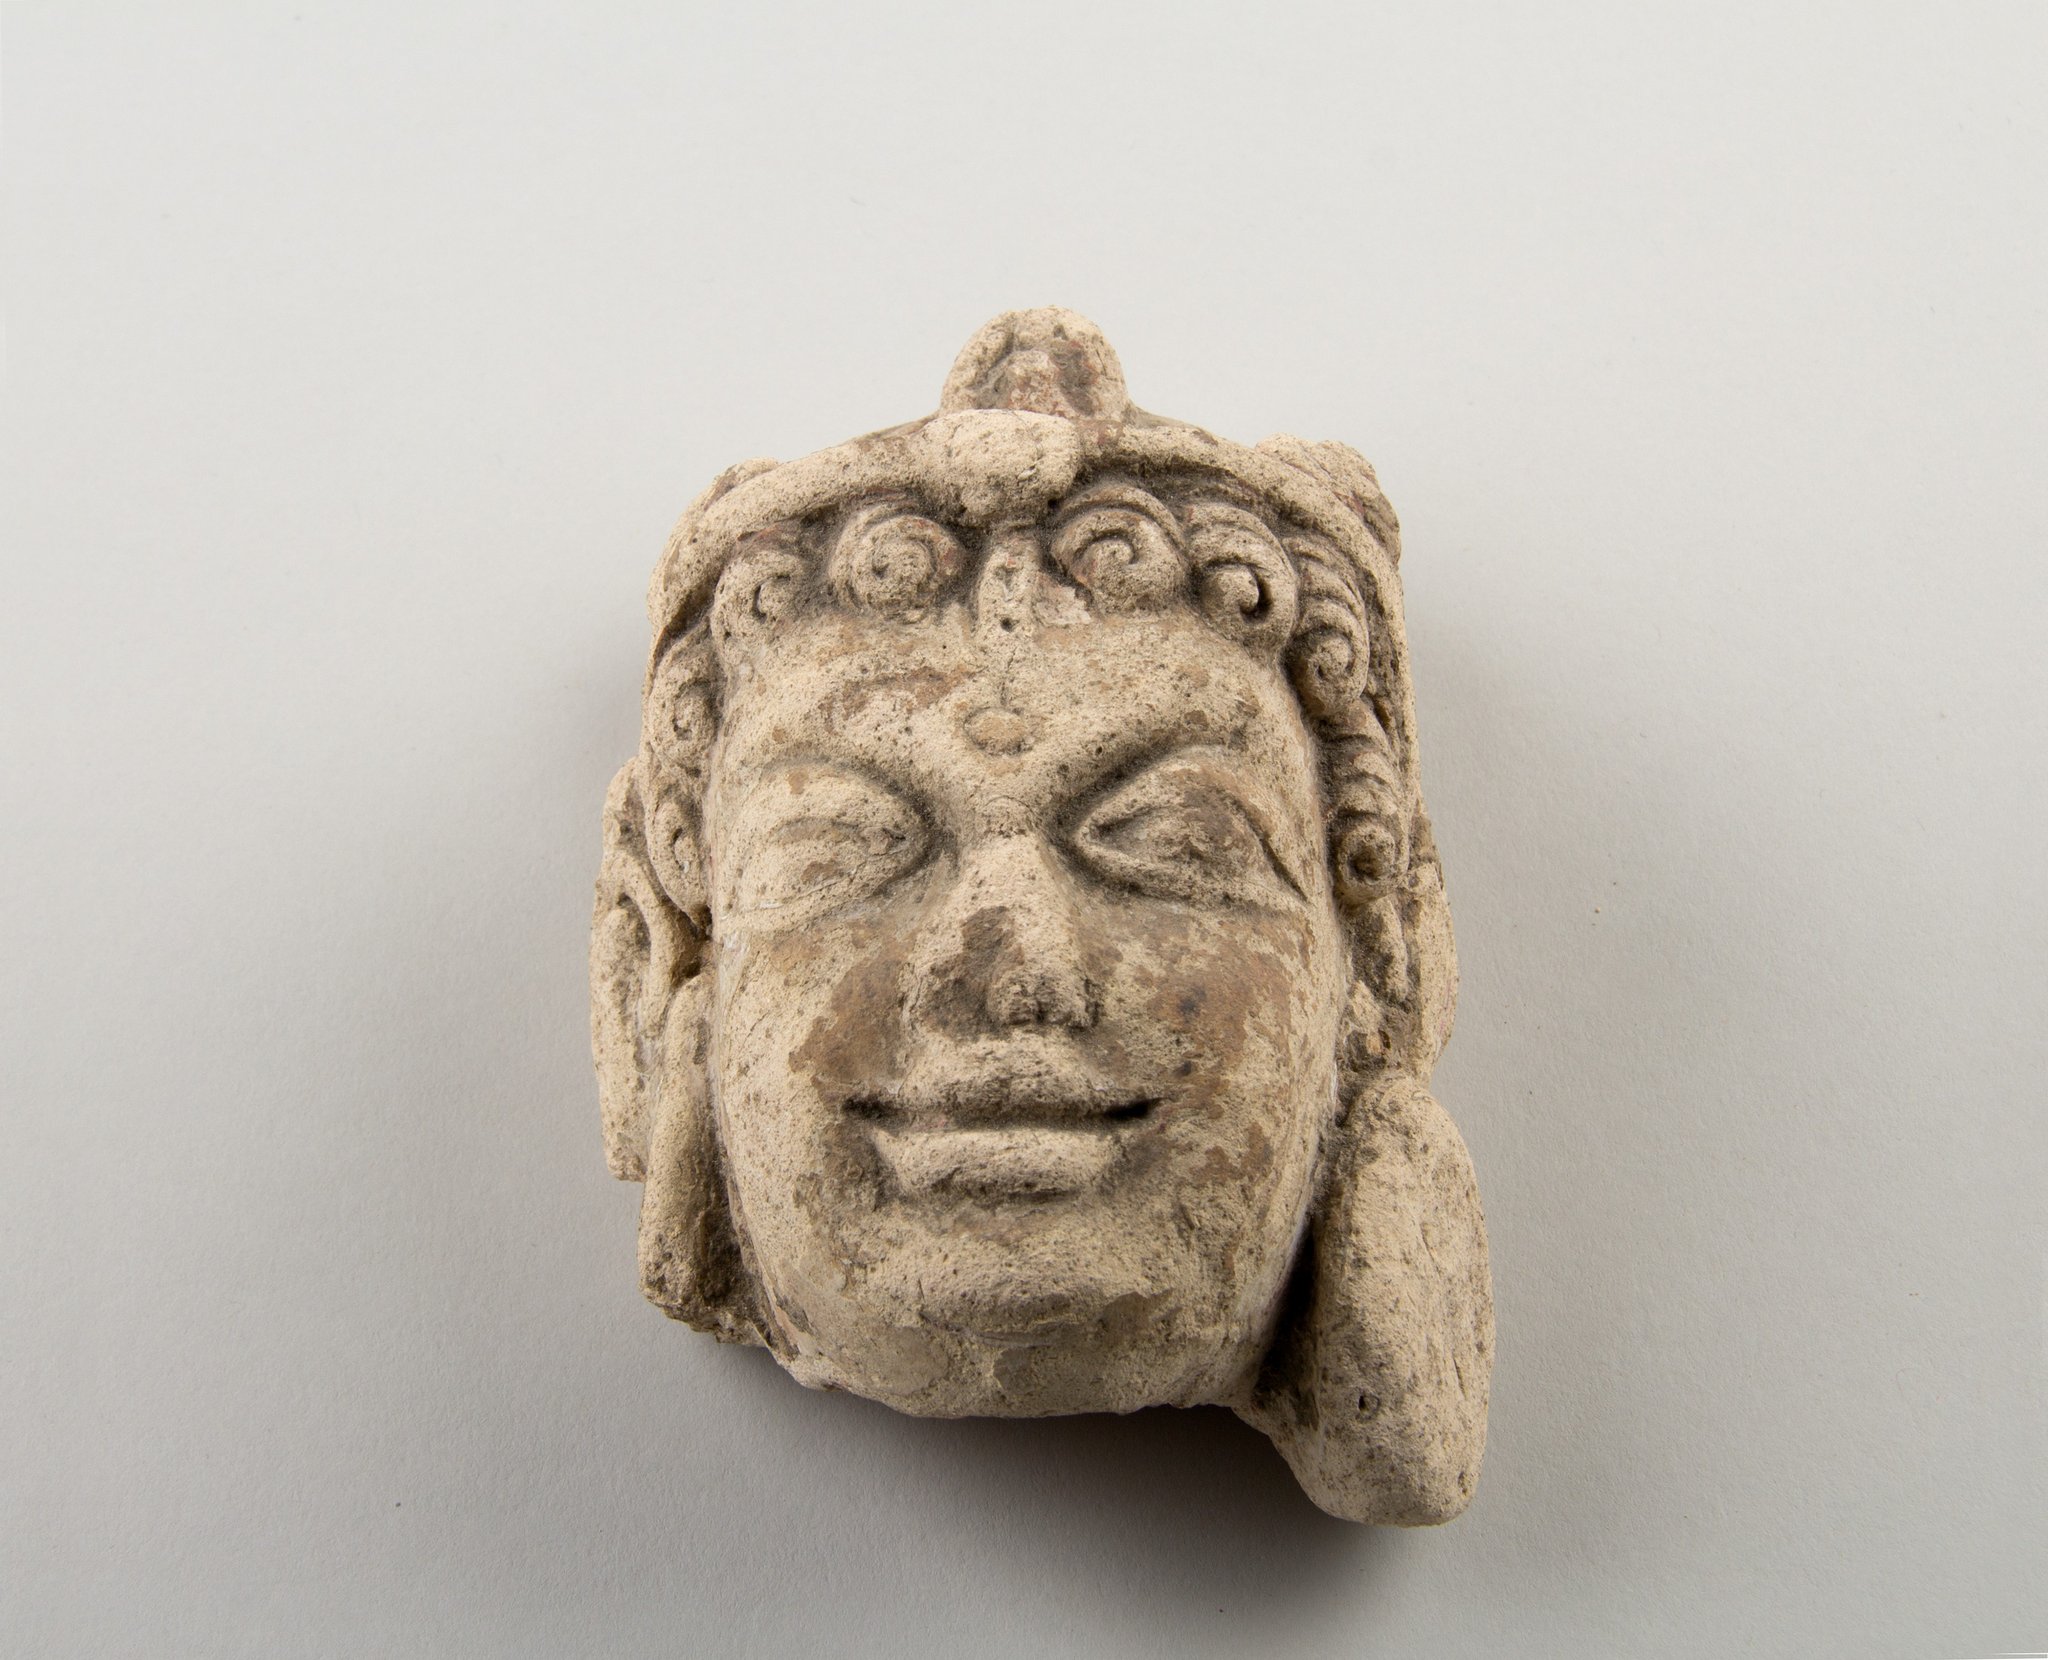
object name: head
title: Head of a Bodhisattva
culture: indian, nalanda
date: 601-800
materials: clay, plaster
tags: heads,buddhism,bodhisattvas